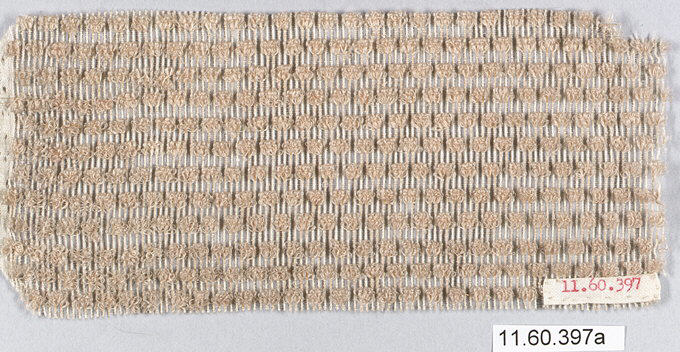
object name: fragment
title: Fragments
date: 1801-1900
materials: silk